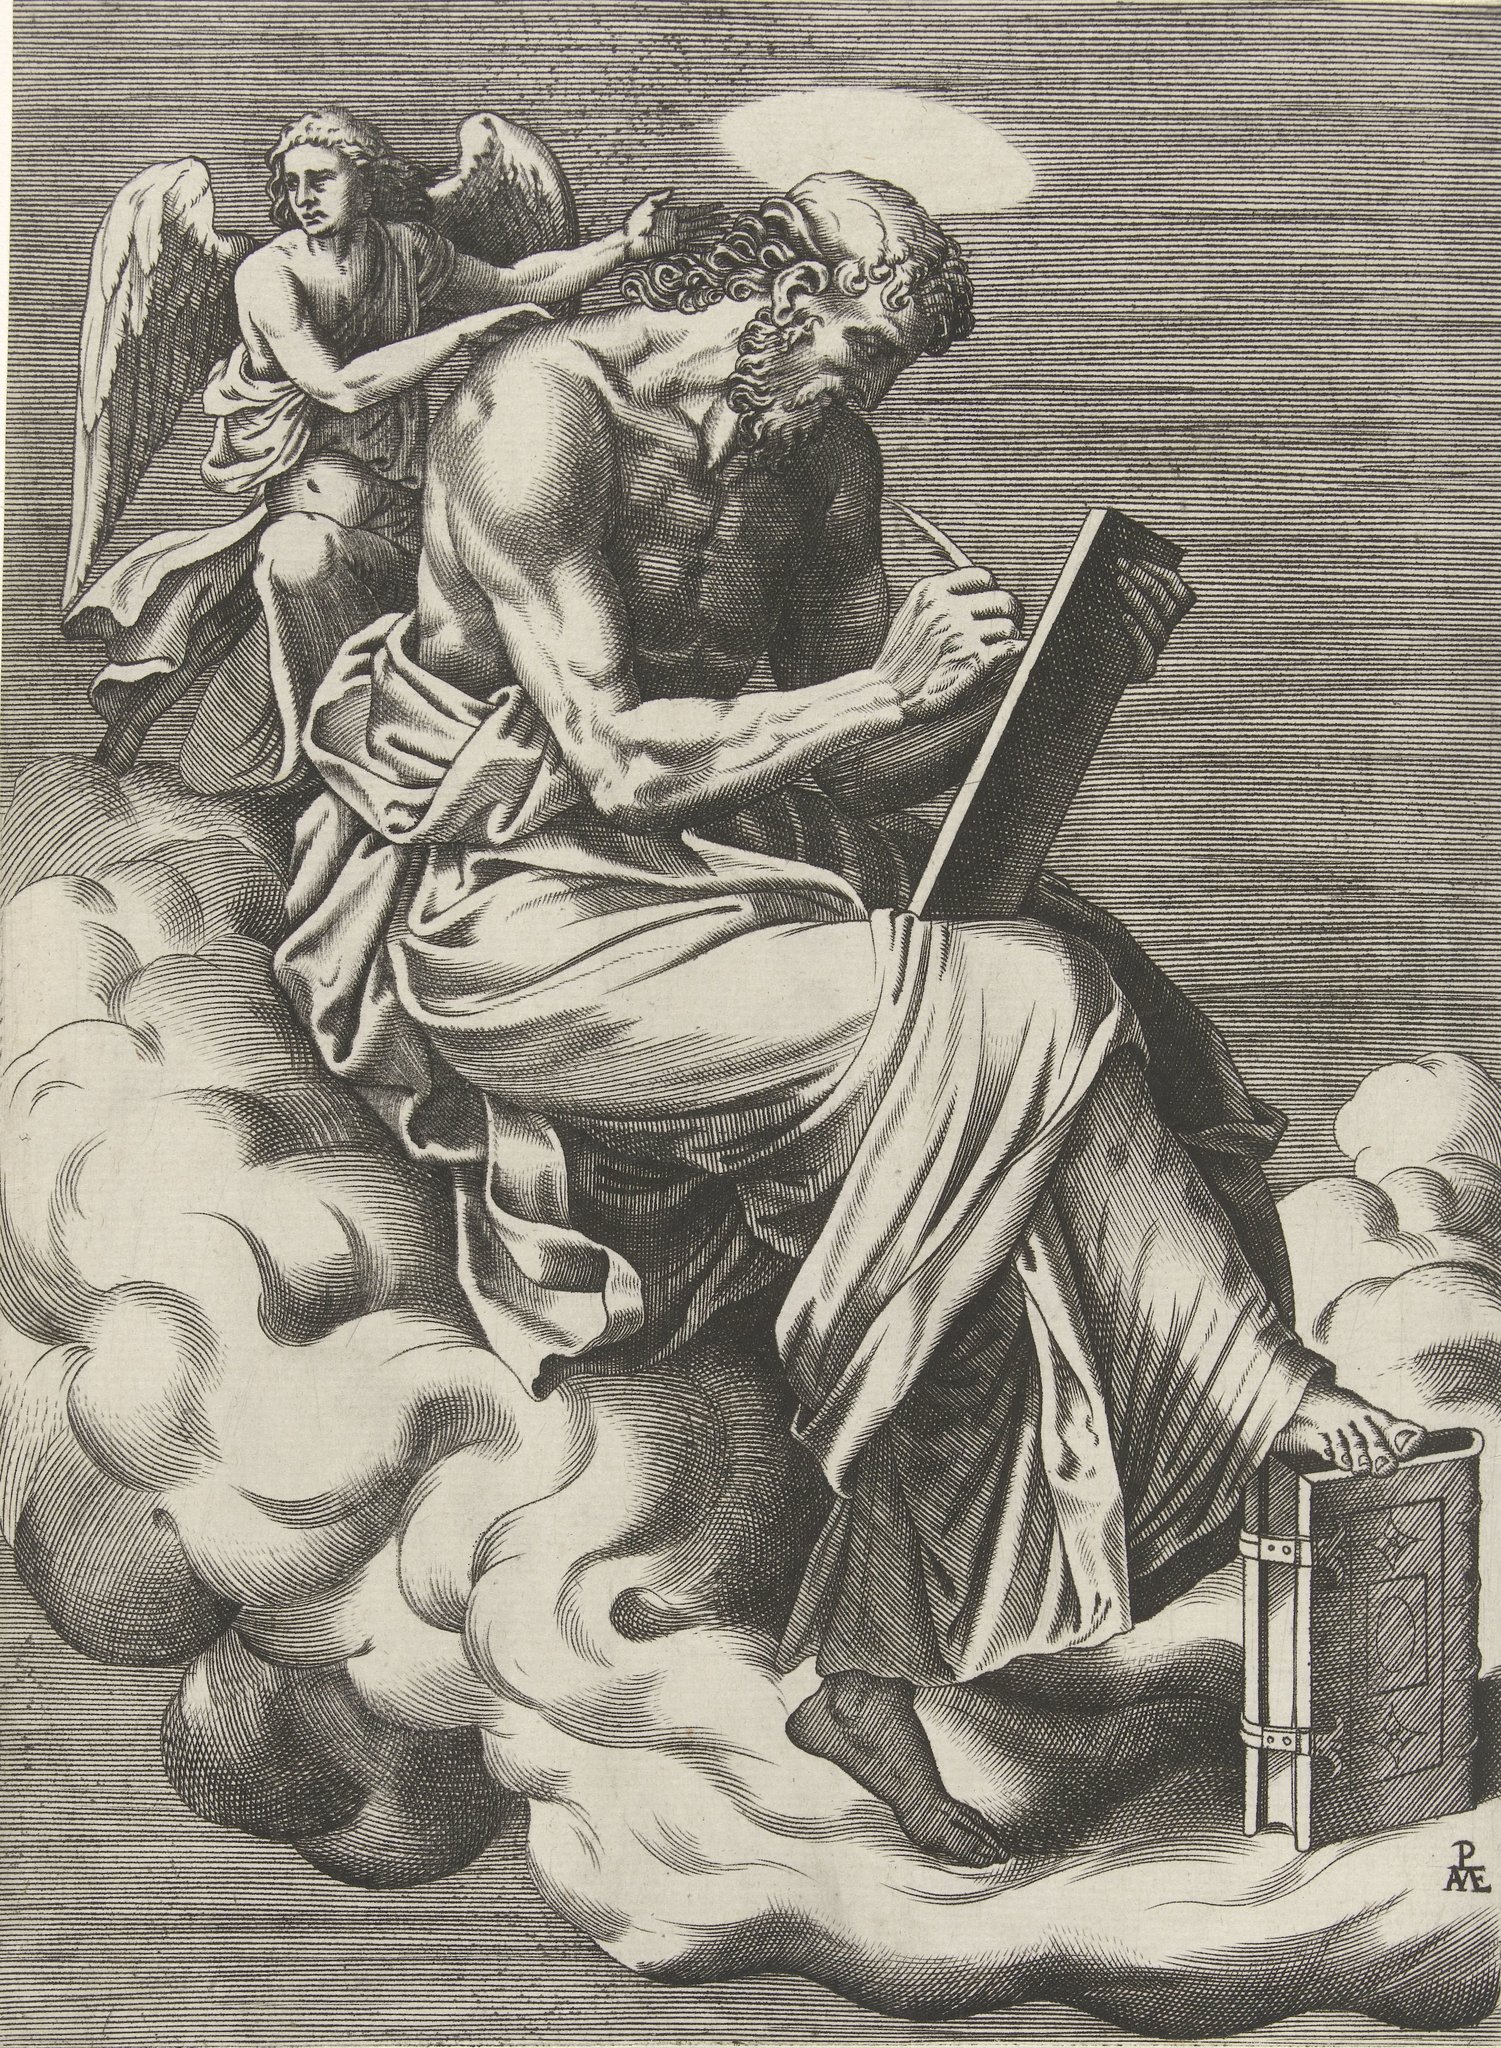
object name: print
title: Matteüs de evangelist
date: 1554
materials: paper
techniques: engraving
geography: antwerp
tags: the apostle and evangelist matthew (mattheus); possible attributes: angel, axe, book, halberd, pen and inkhorn, purse, scroll, square, sword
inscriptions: collector's mark: Lugt 2228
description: De evangelist Matteüs zittend op een wolk met achter zijn rug zijn attribuut, een van de vier apocalyptische wezens, de engel of gevleugeld mens. Prent uit een serie van vier.